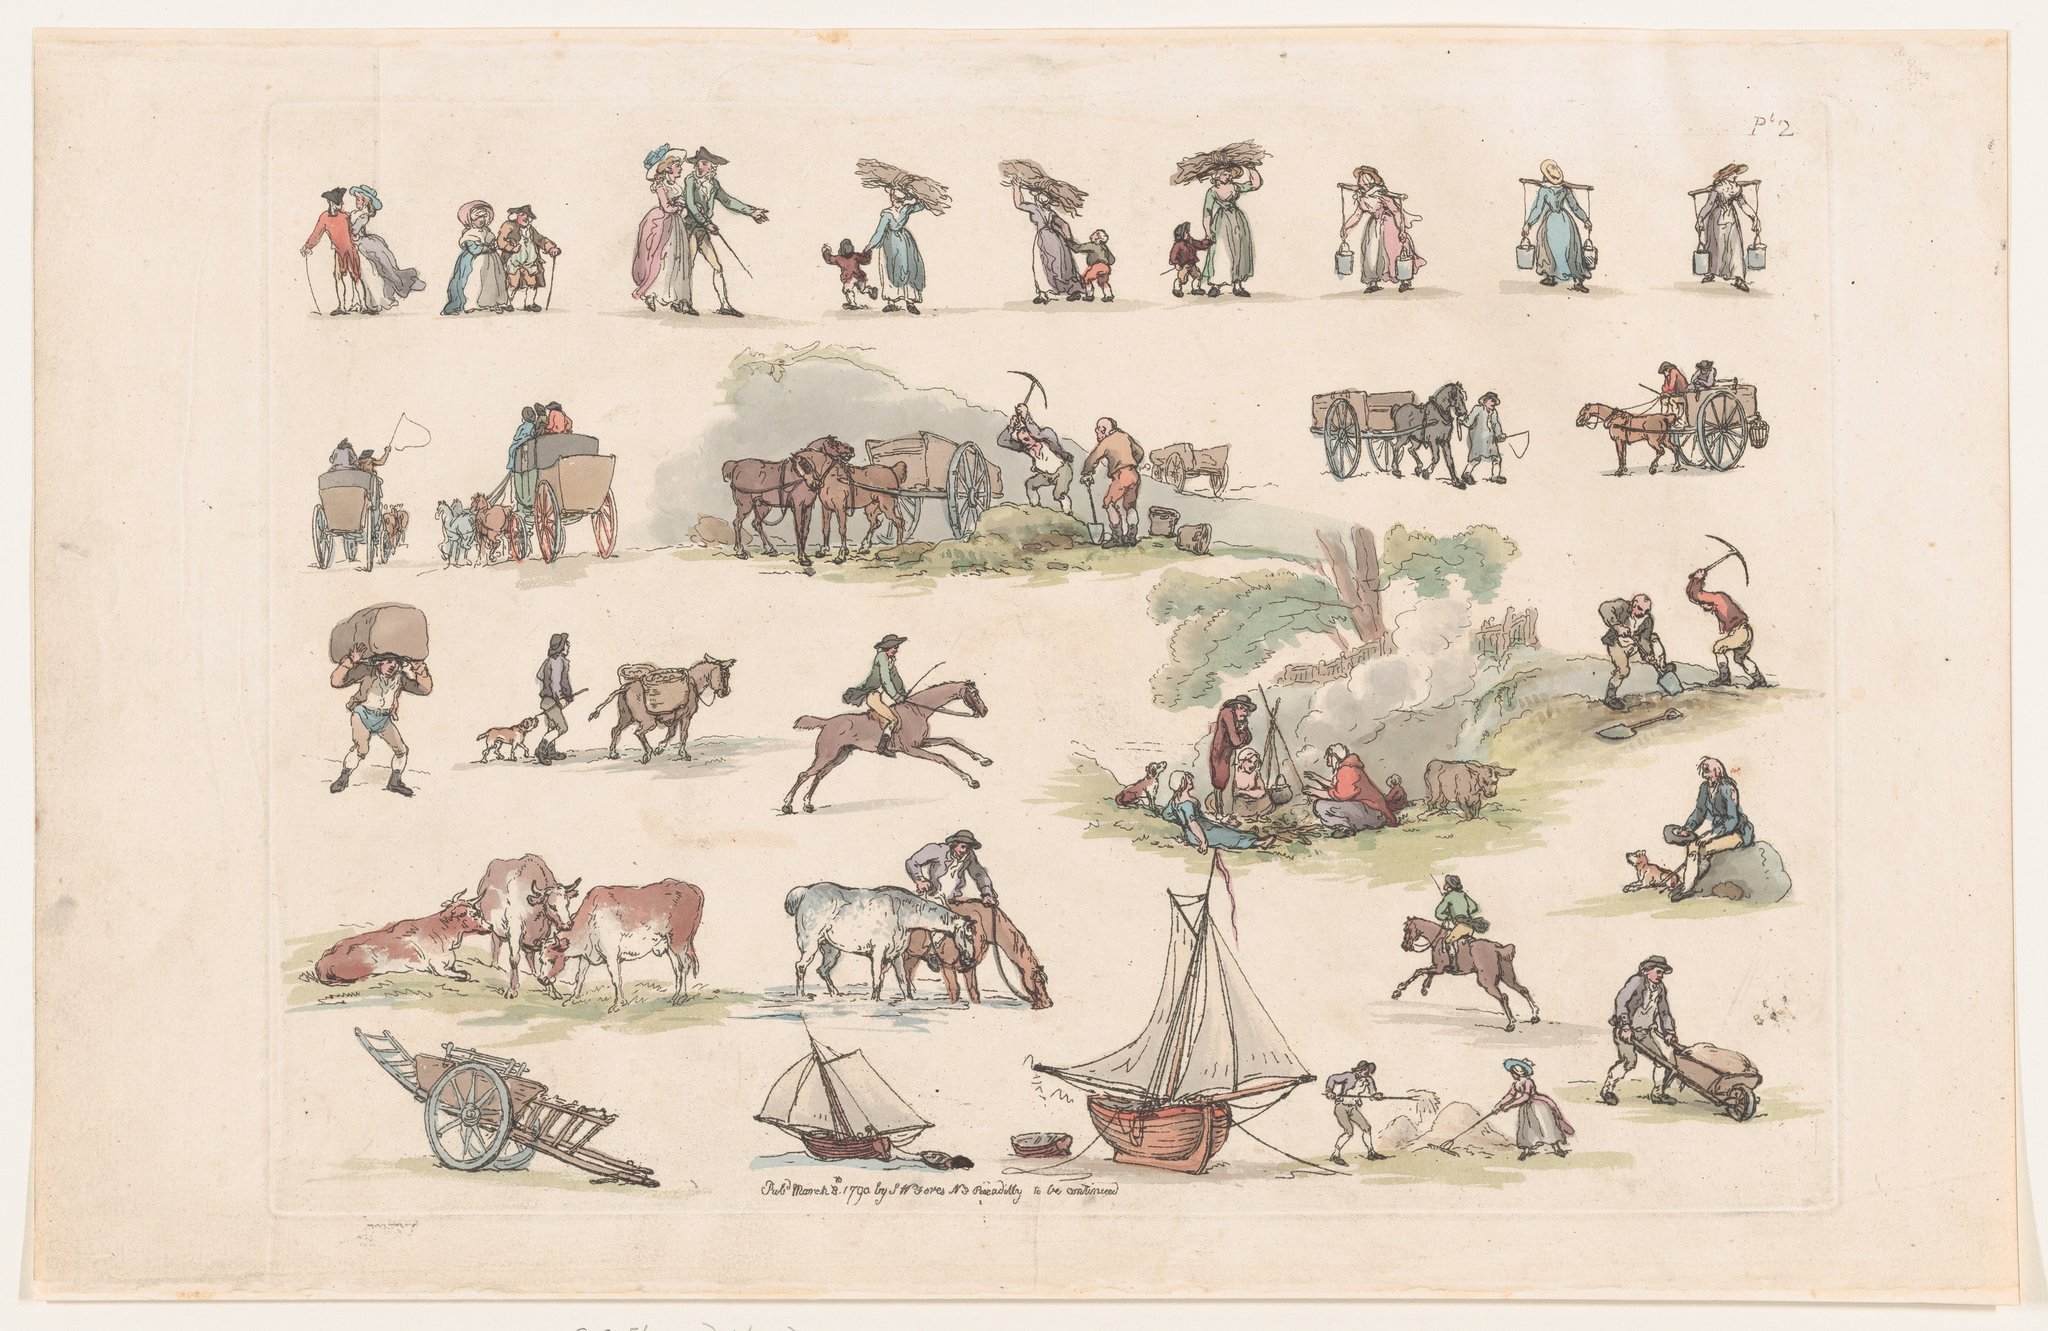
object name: print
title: Plate 2, Outlines of Figures, Landscapes and Cattle...for the Use of Learners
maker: thomas rowlandson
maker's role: artist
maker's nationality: british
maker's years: 1757-1827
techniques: etching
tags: men,cows,horses,boats